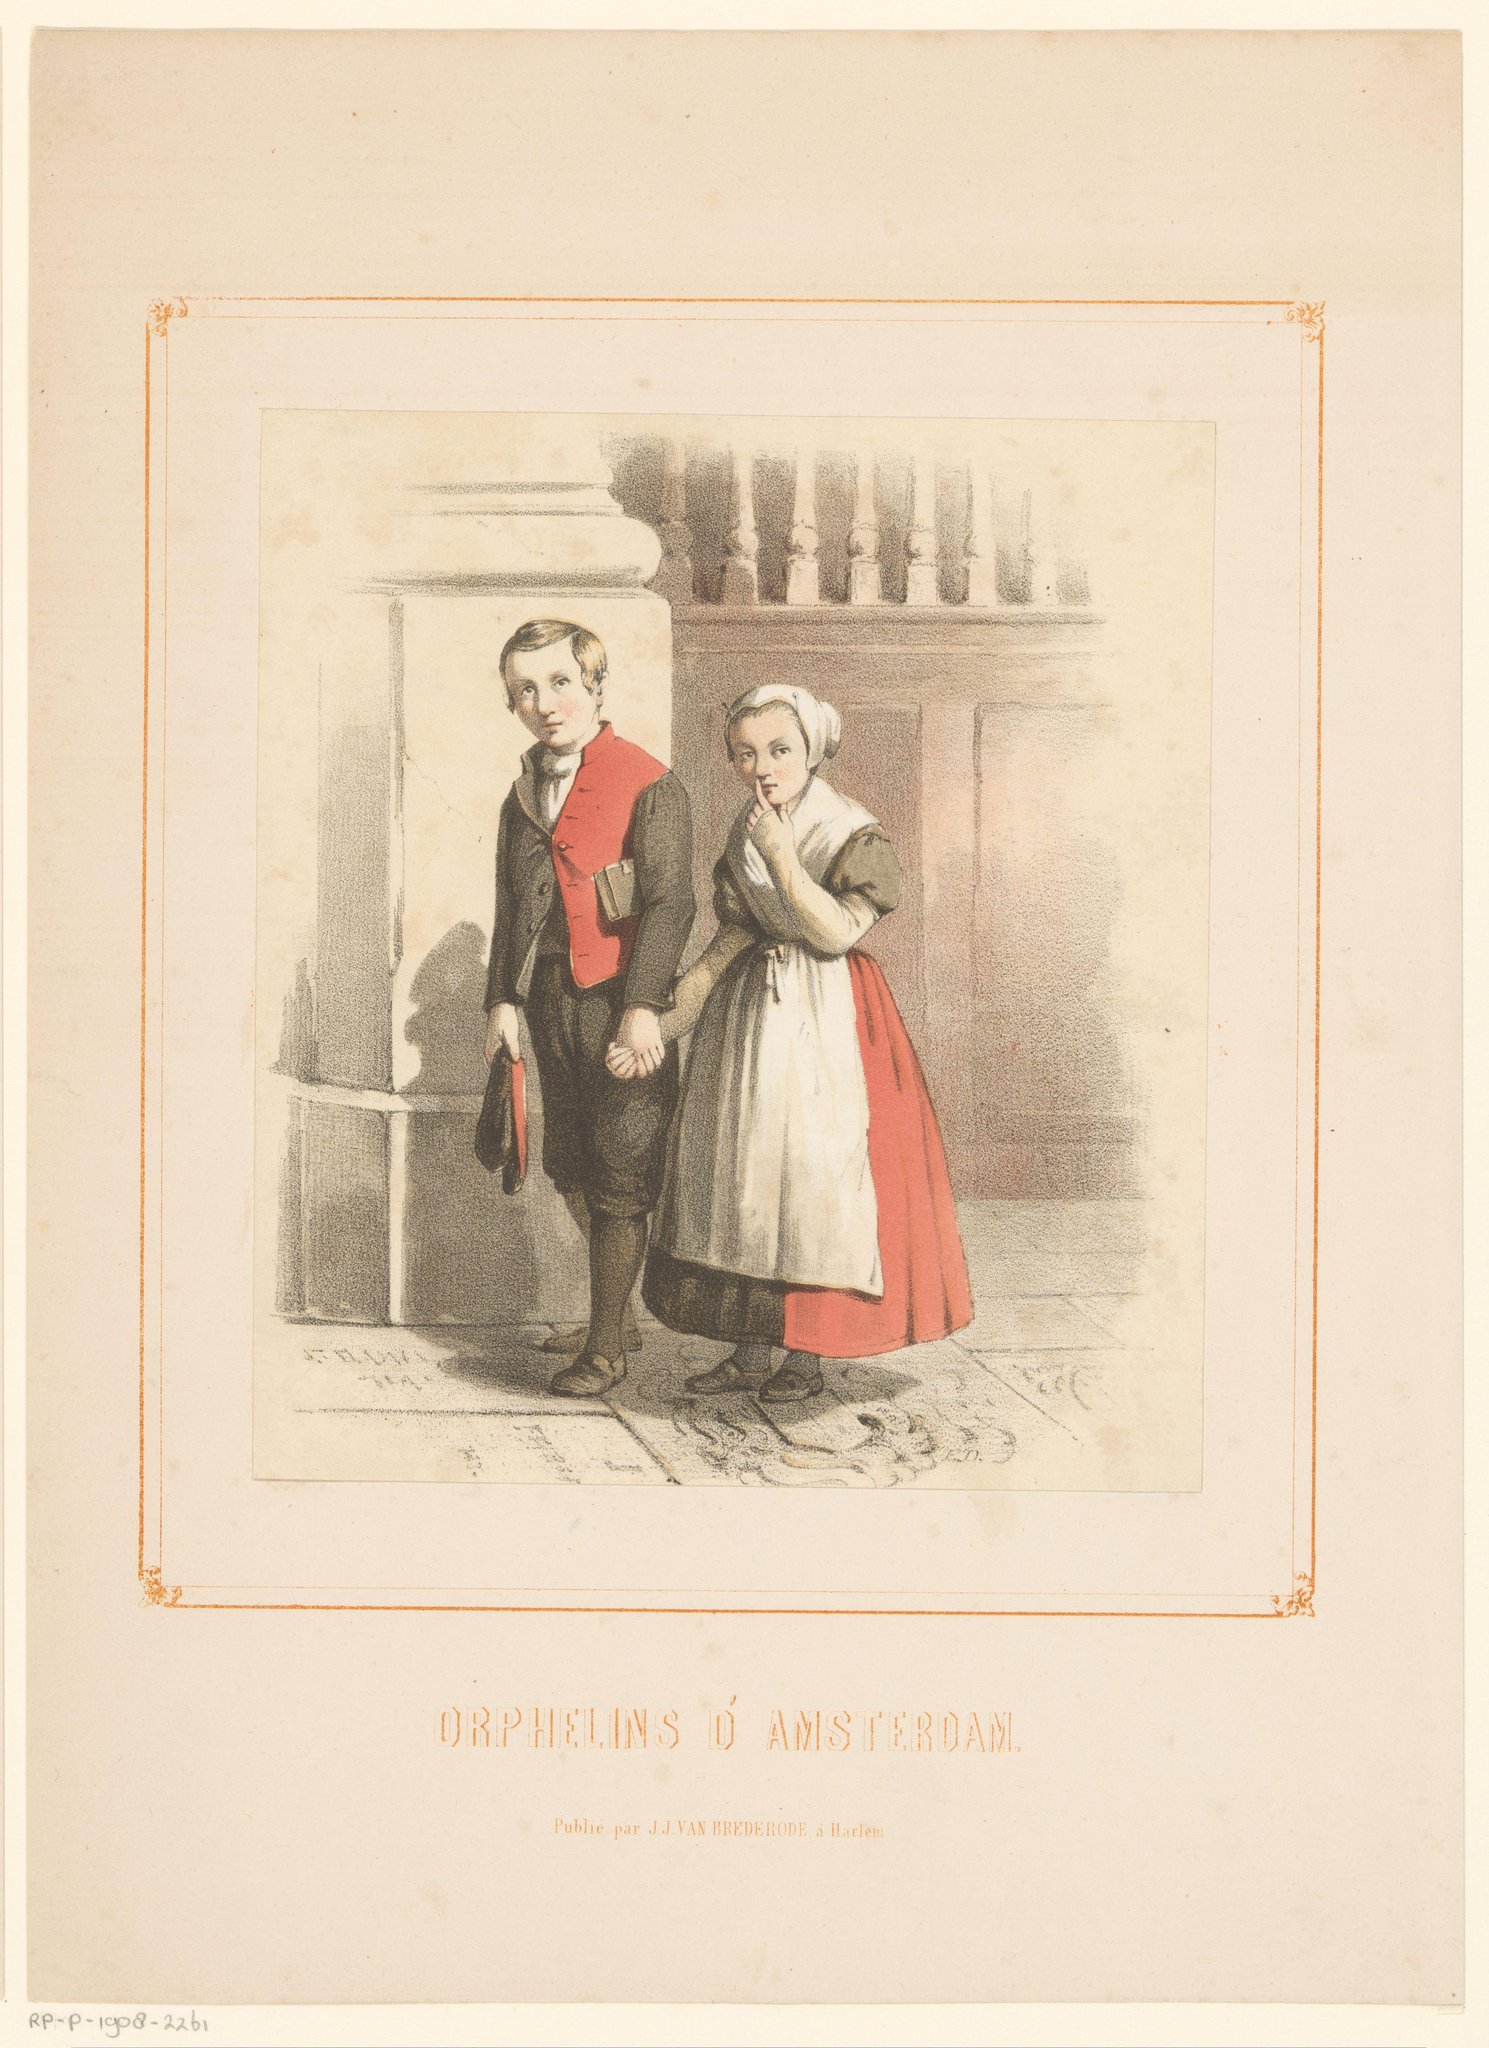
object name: print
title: Orphelins d'Amsterdam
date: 1849-1873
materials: paper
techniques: lithograph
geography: haarlem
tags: leading someone by the hand or wrist, folk costume, regional costume, orphans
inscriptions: collector's mark: Lugt 2228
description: De jongen en het meisje houden elkaars hand vast. Zij staan in een kerk.